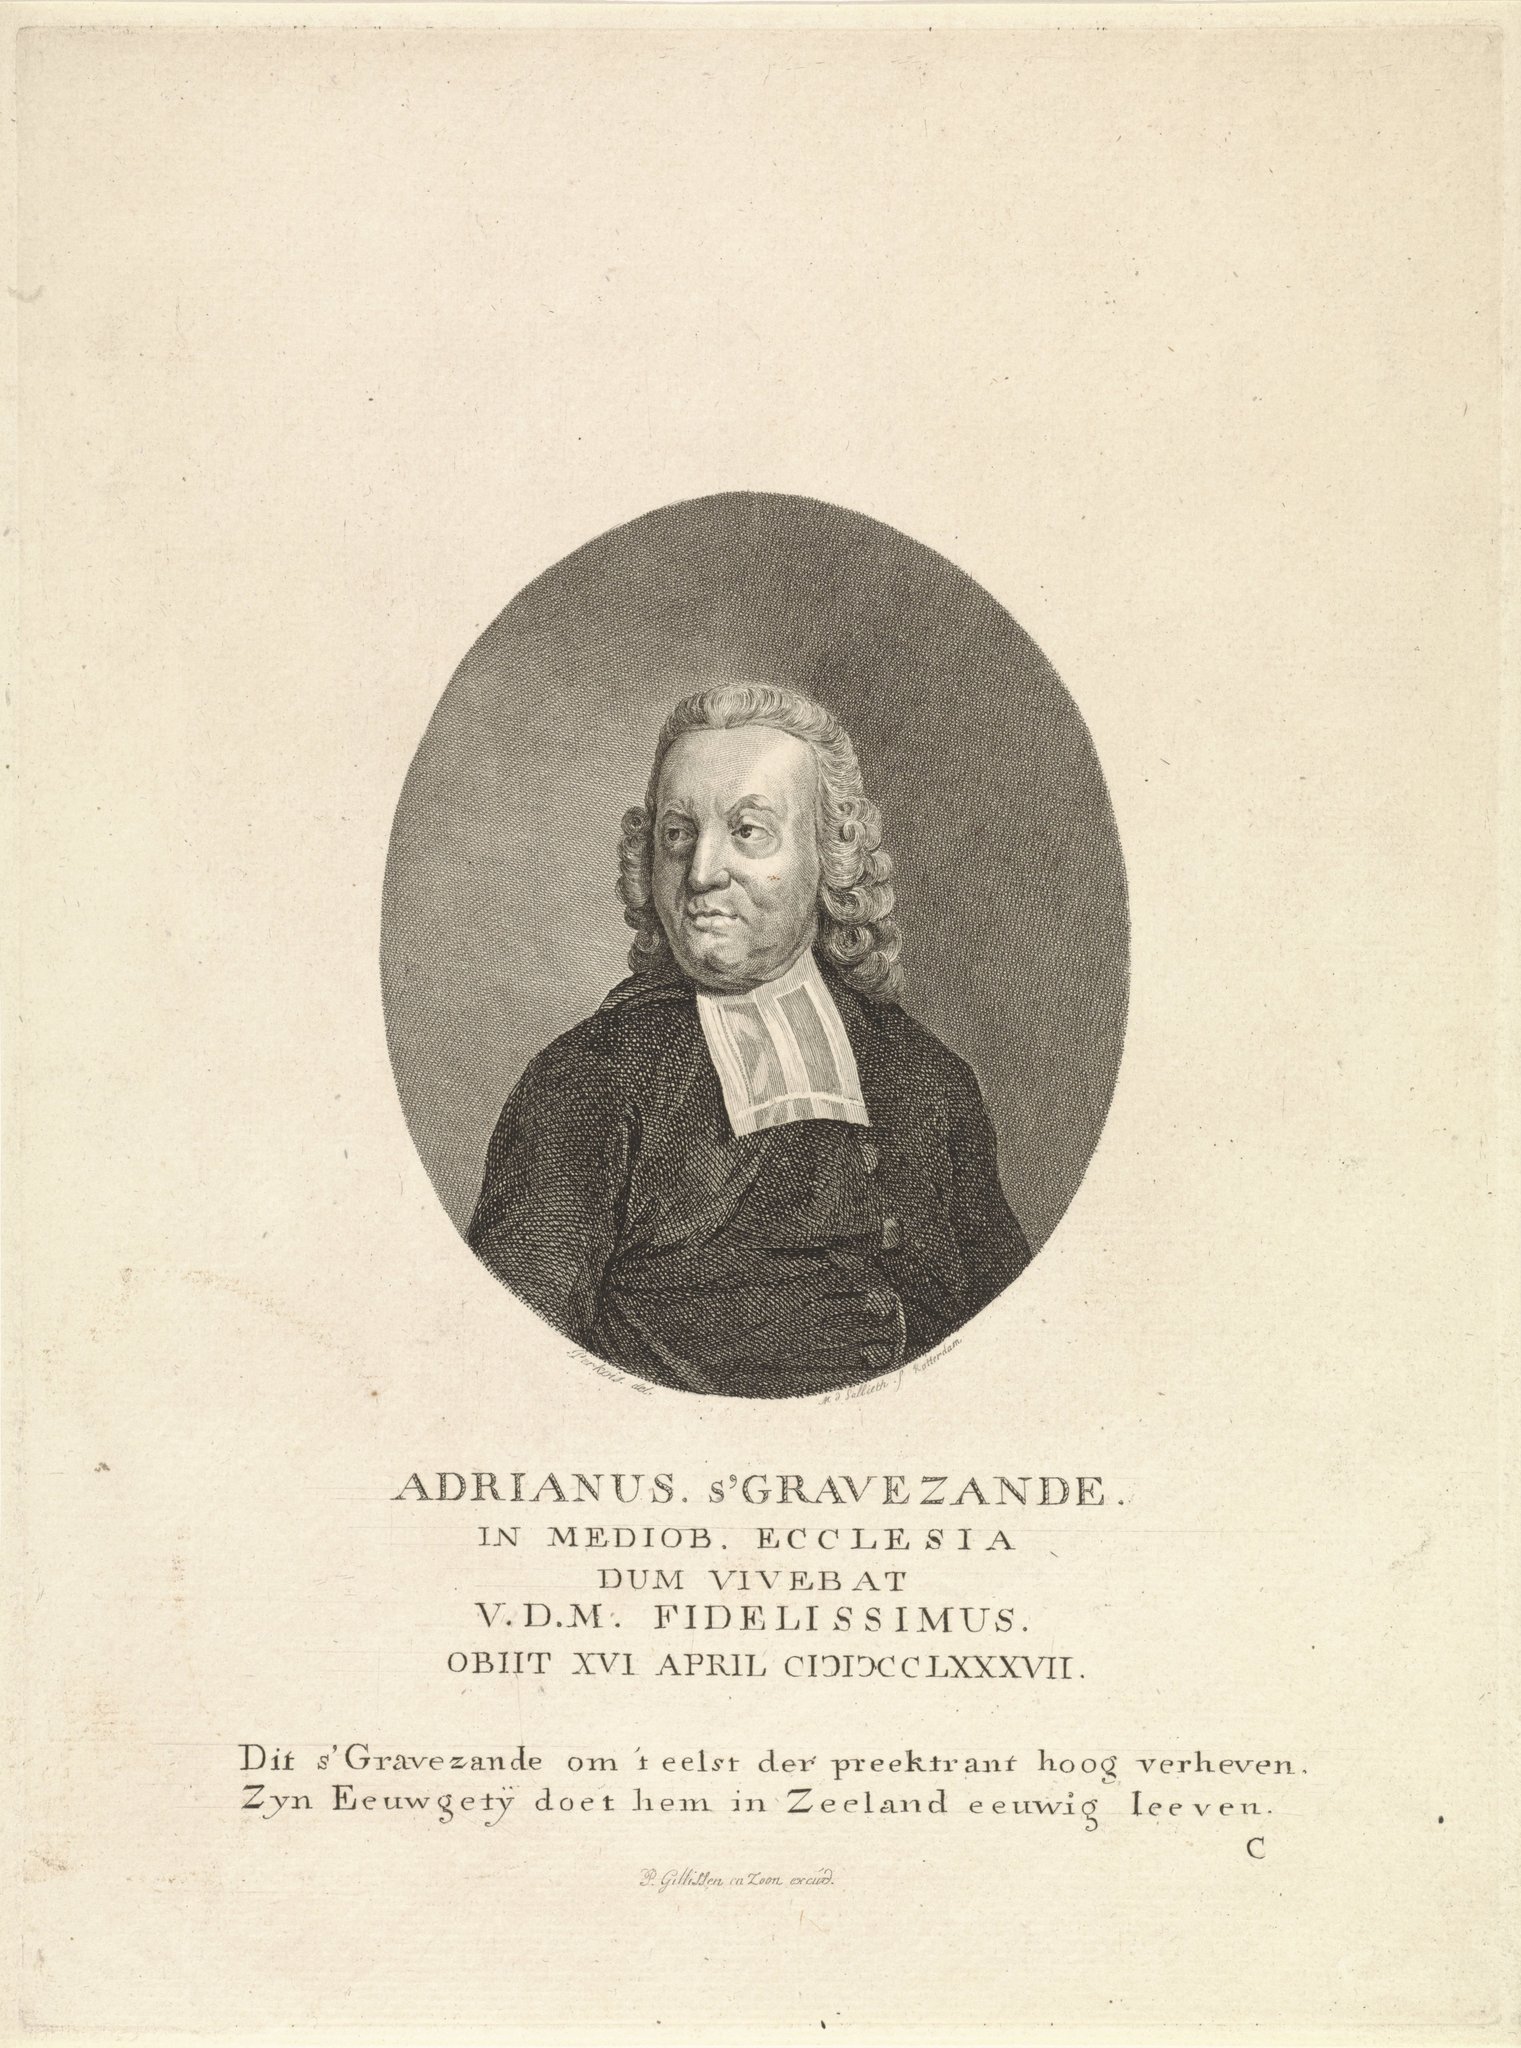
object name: print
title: Portret van de Zeeuwse predikant Adriaan 's Gravezande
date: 1787-1790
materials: paper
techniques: etching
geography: rotterdam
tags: predikant, adriaan 's- gravezande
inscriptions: collector's mark: Lugt 2228